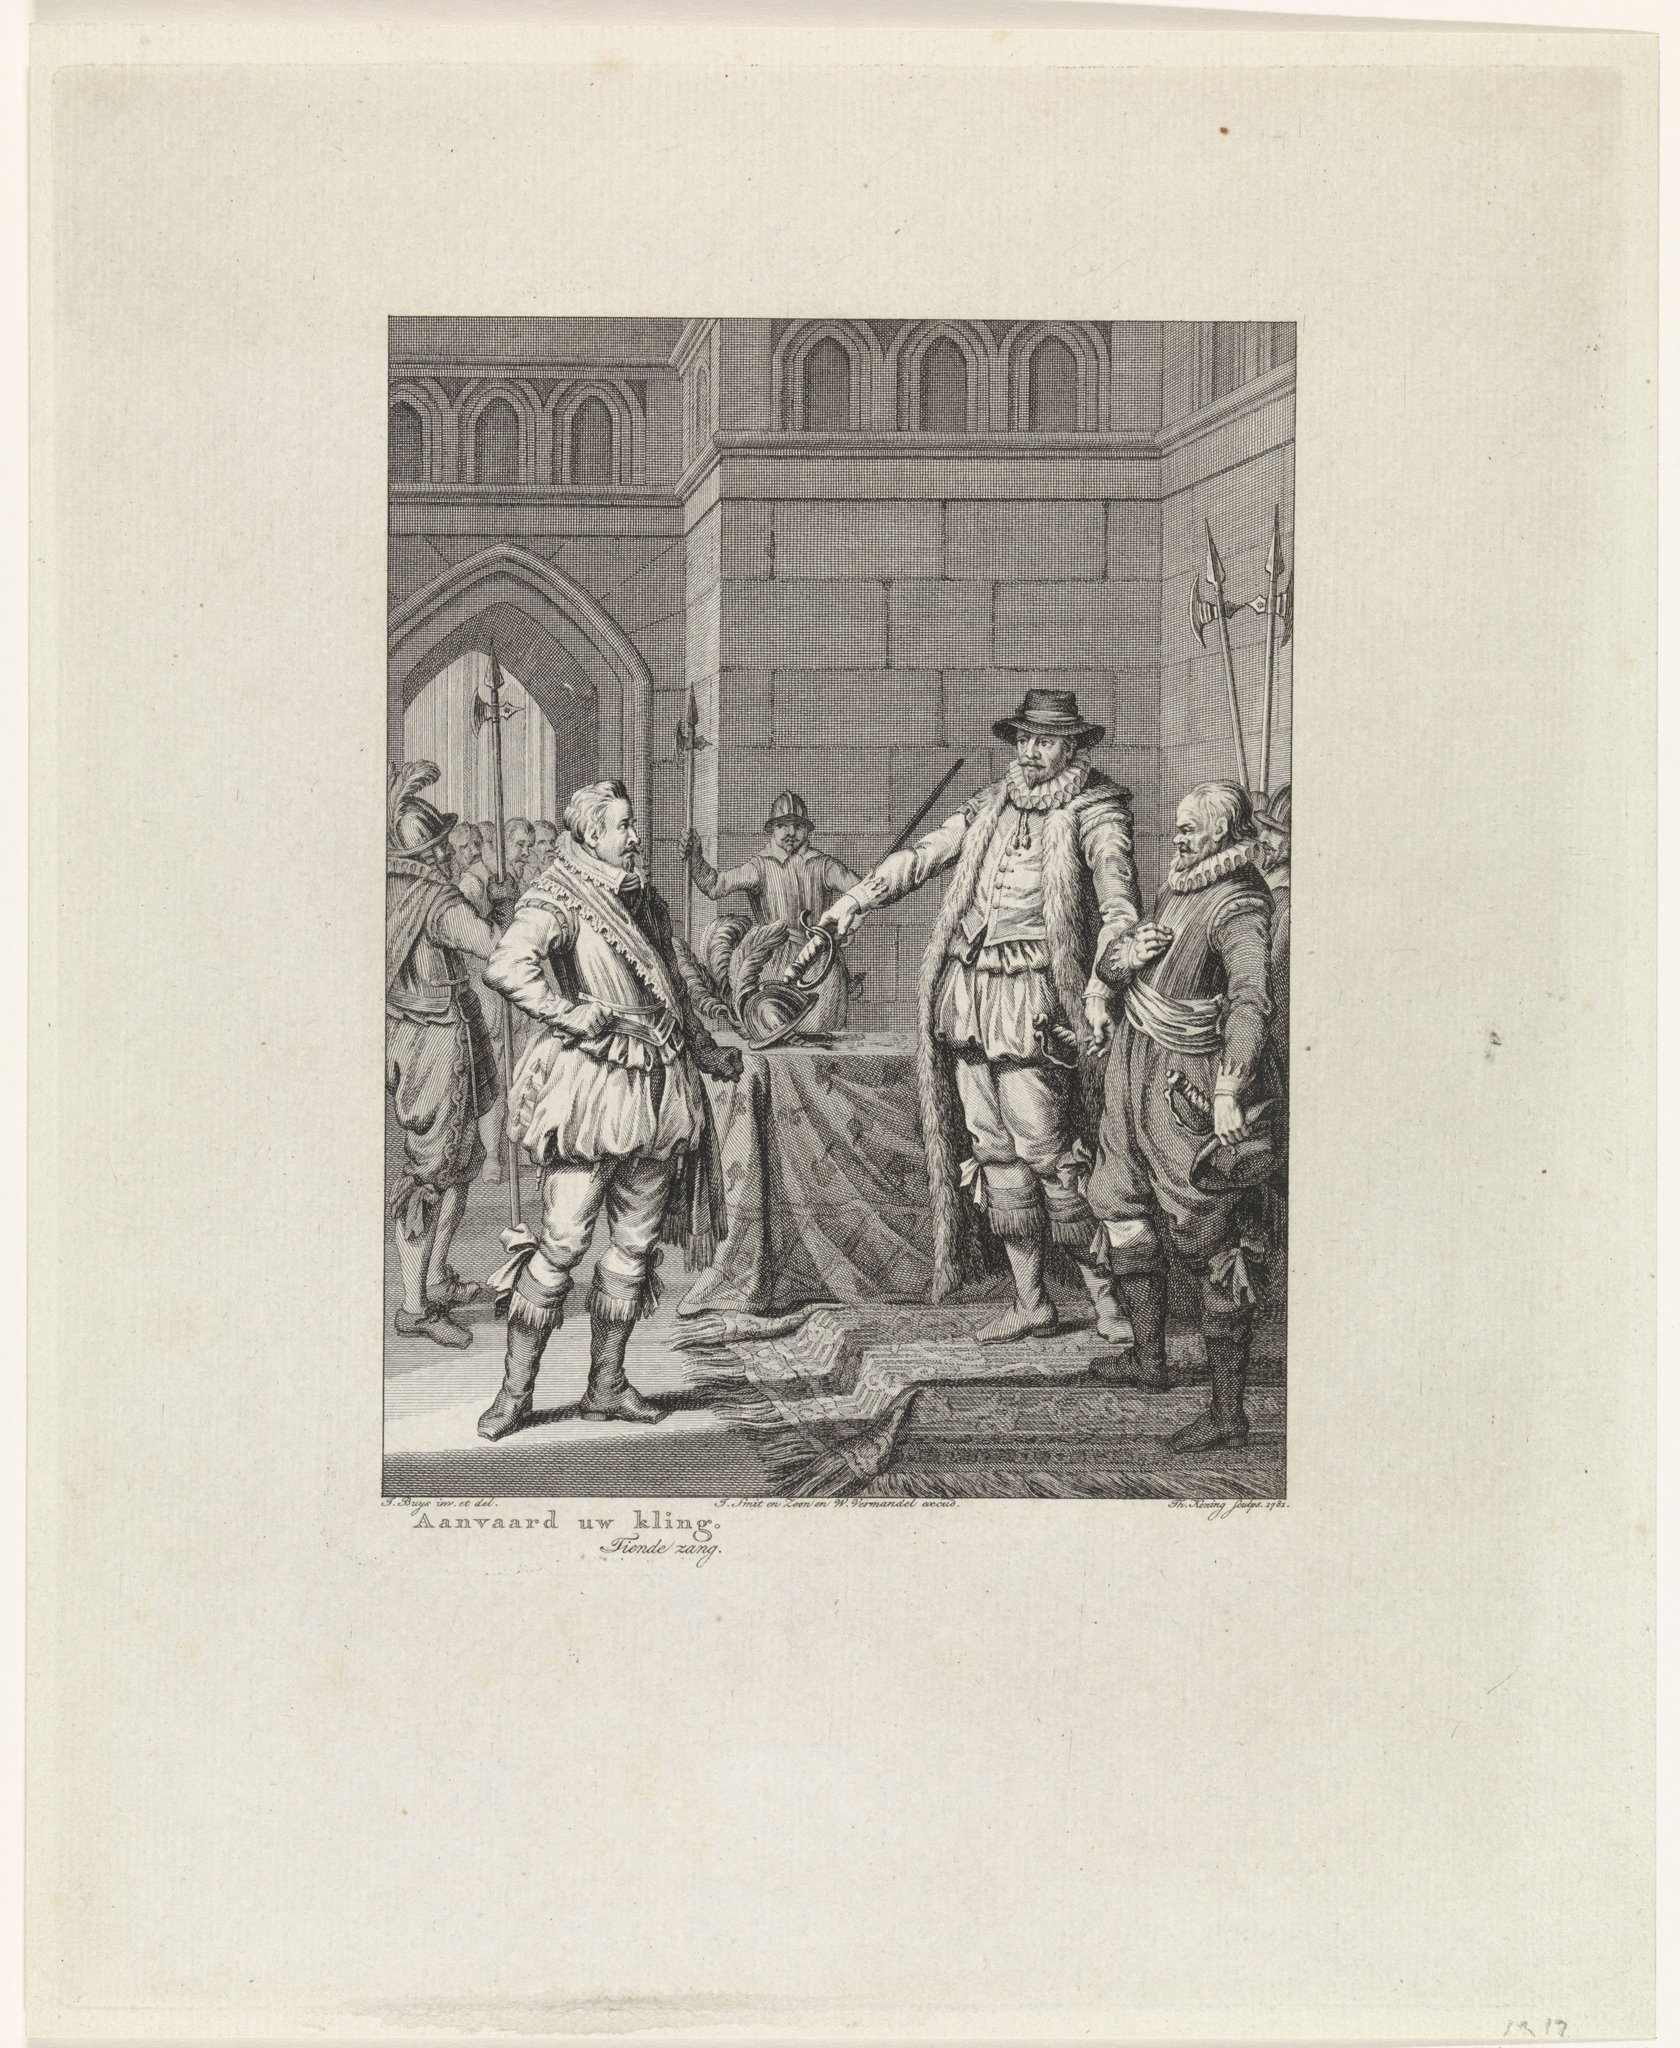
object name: print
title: Oranje geeft Bossu te Hoorn zijn zwaard terug, 1573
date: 1781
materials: paper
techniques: engraving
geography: amsterdam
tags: delft, william i (prince of orange), earl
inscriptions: collector's mark: Lugt 2228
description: Willem van Oranje geeft Bossu te Hoorn zijn zwaard terug, 1573. Deze prent maakt deel uit van een serie van 24 prenten met taferelen uit het leven van prins Willem I, 1568-1584 en is een illustratie bij de tiende zang.